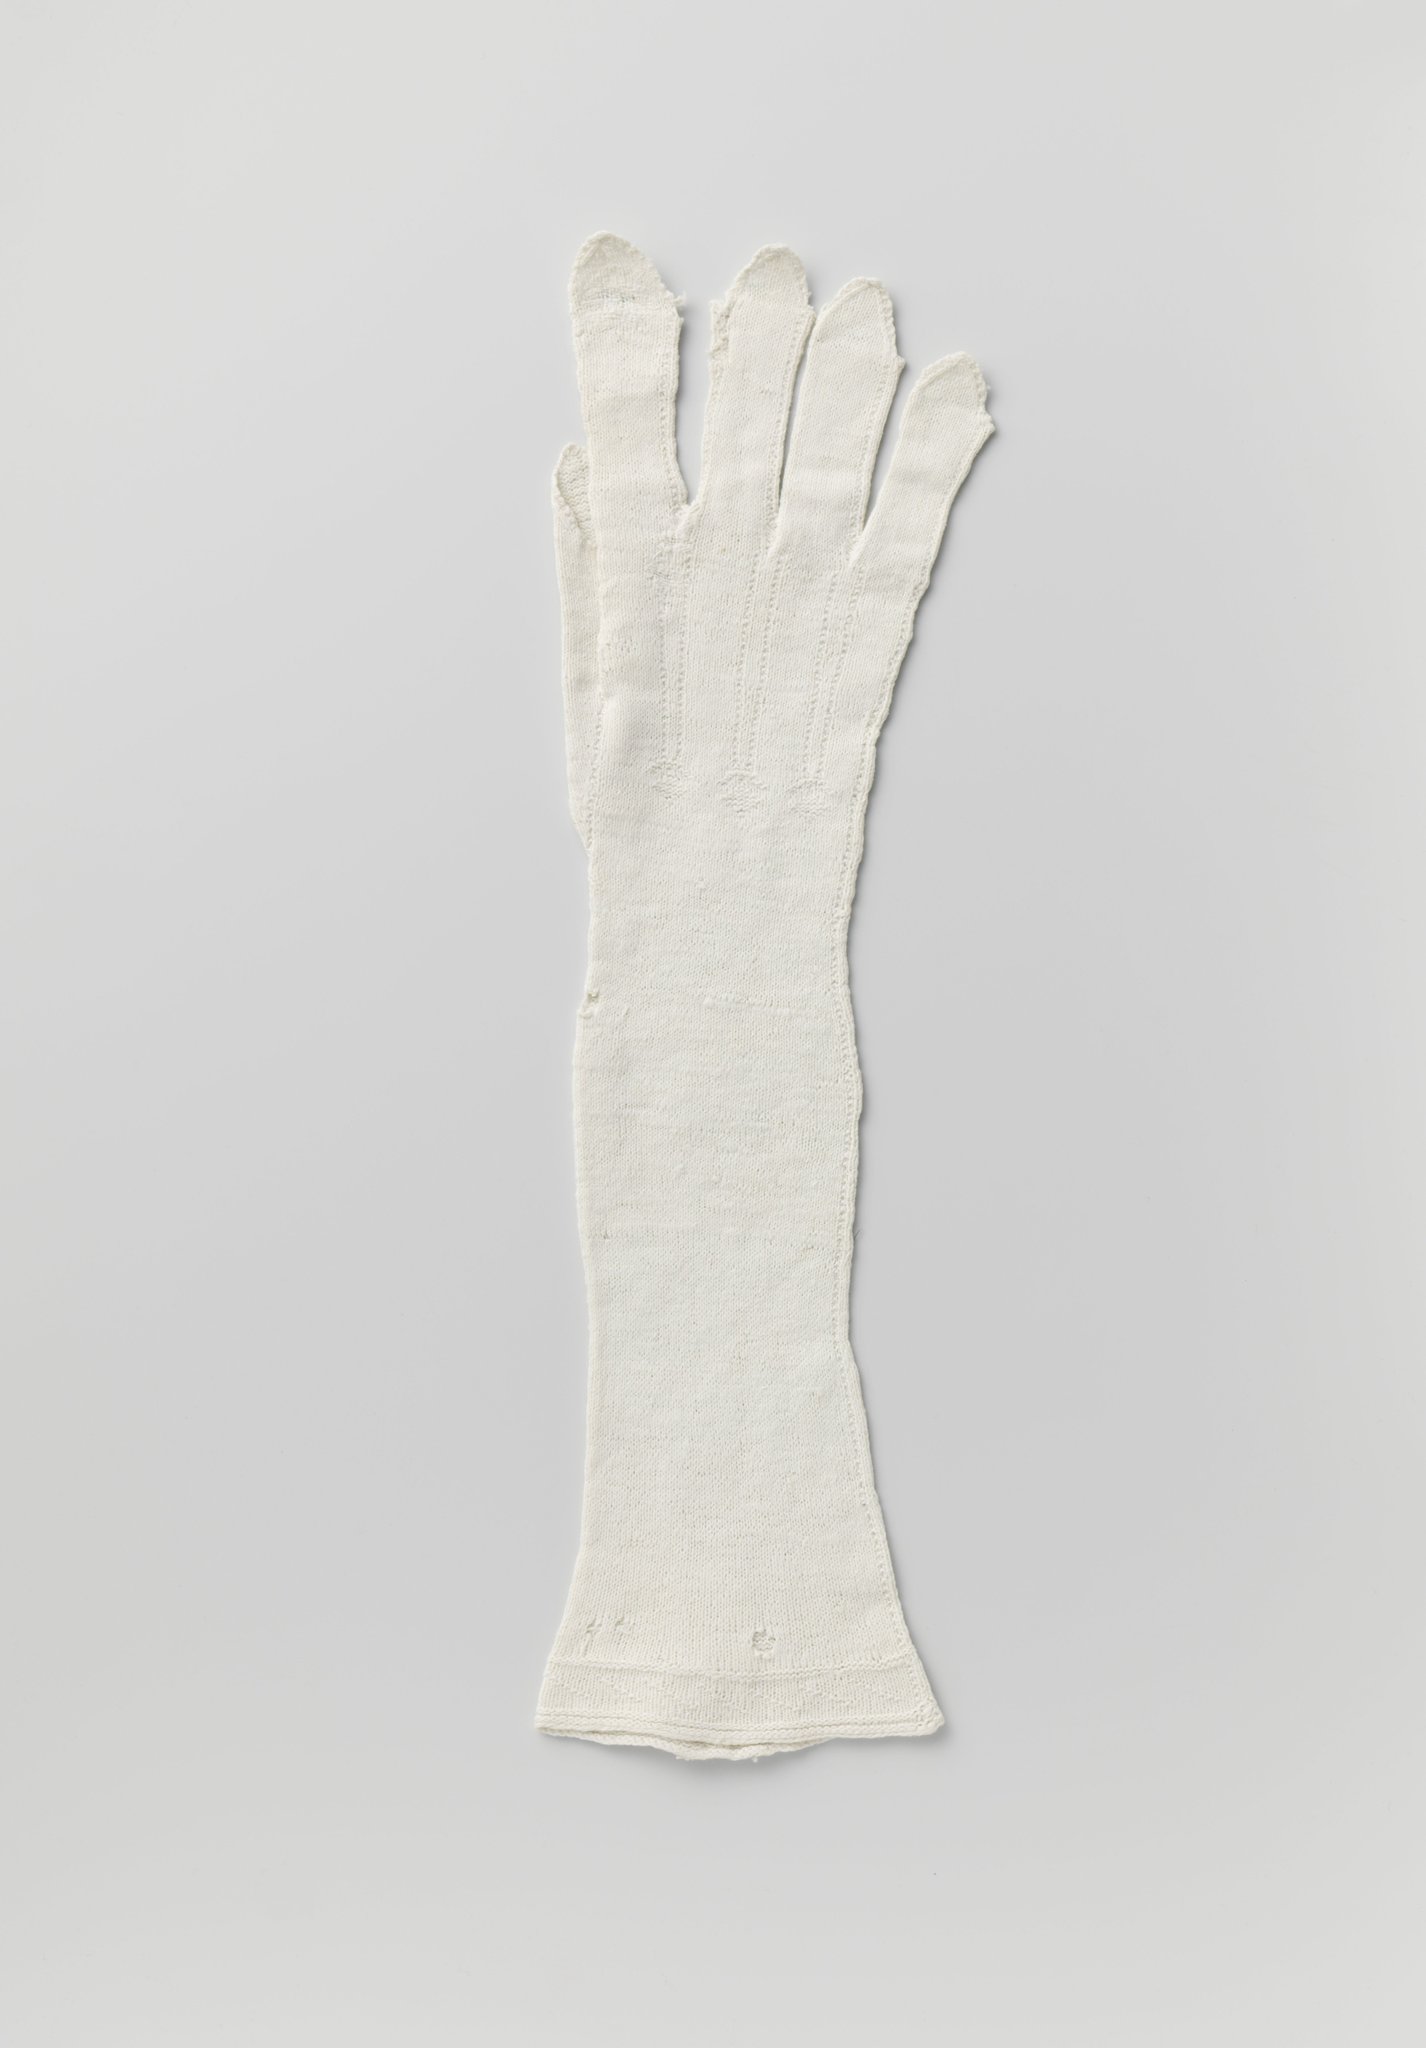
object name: glove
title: Handschoen van witte katoen gebreid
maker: Anonymous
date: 1850-1900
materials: cotton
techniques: knitting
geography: western europe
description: Gebreide handschoen van witte katoen met open vingertoppen. Op de handrug drie dubbele peesstrepen.